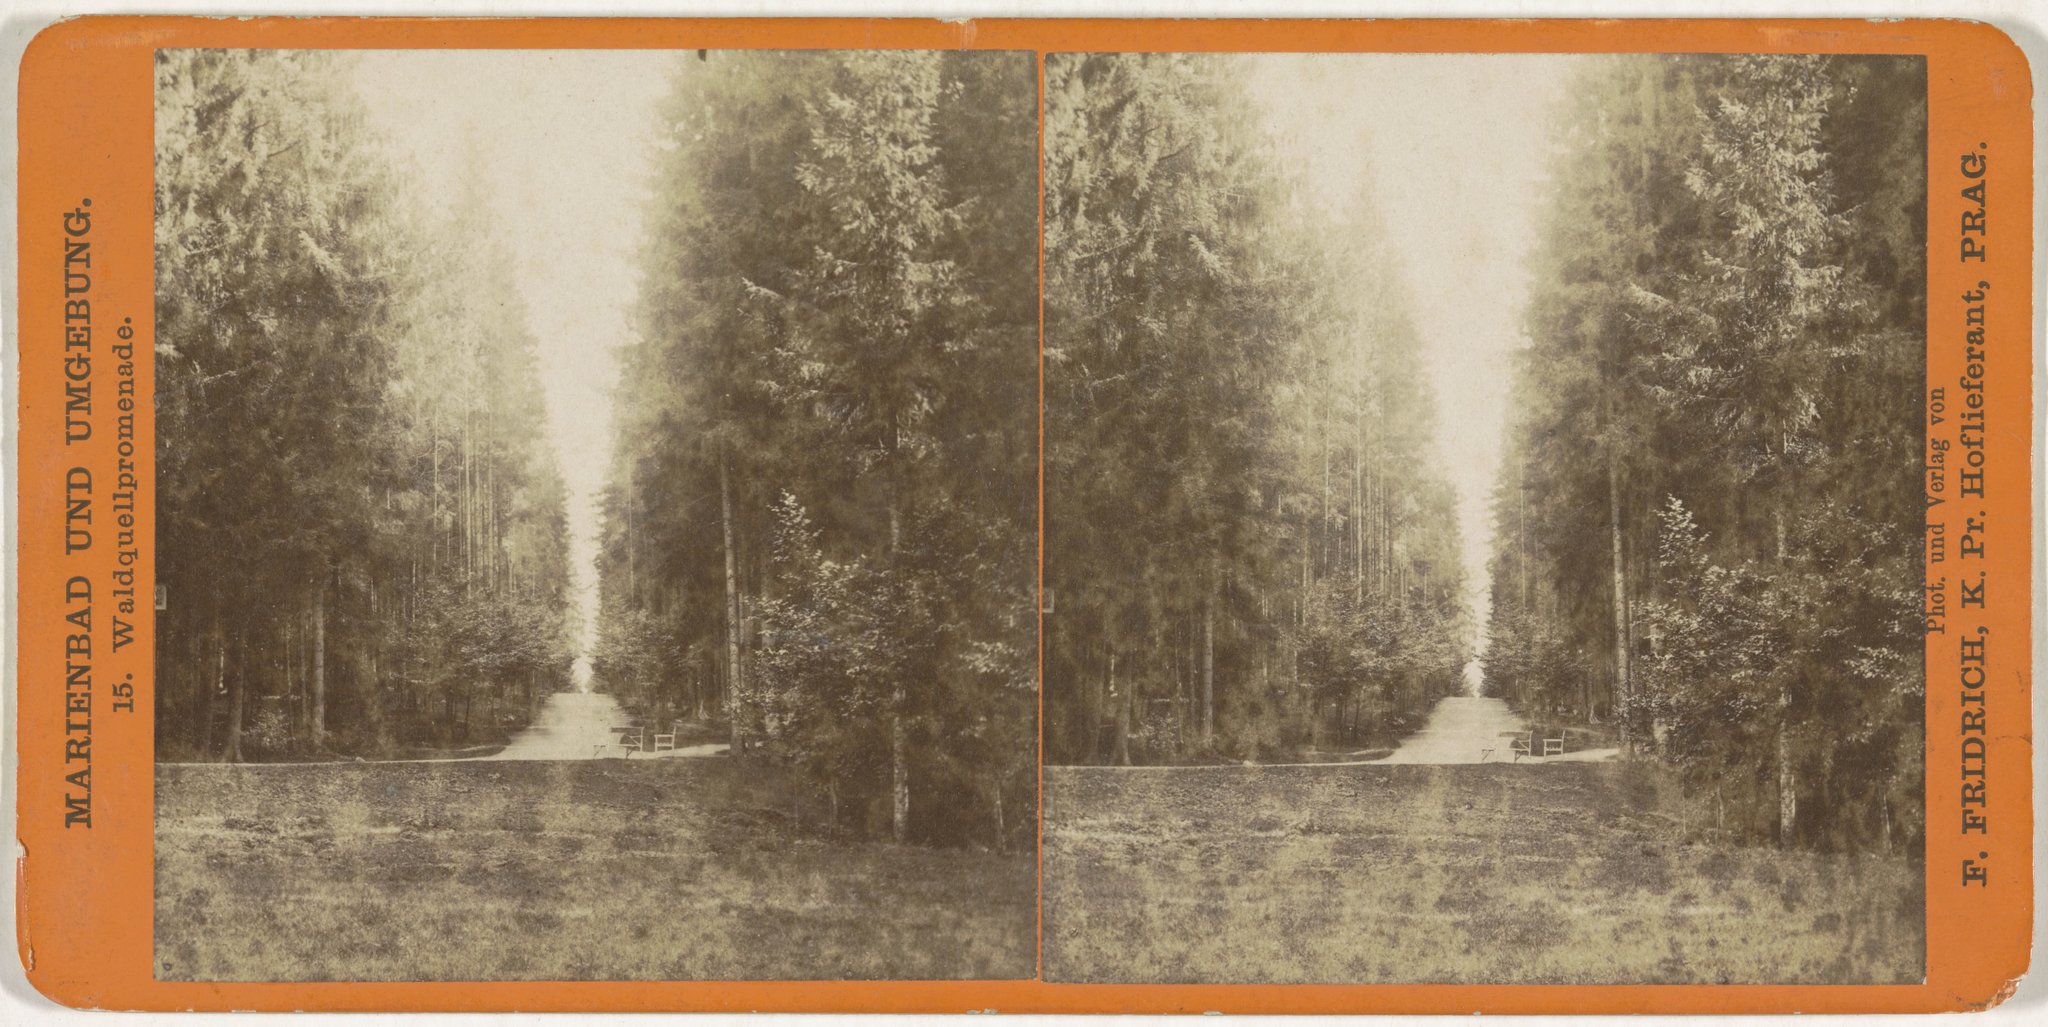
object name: stereograph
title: Marienbad und Umgebung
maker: františek fridrich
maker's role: publisher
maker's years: 1829-1892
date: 1855-1868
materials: cardboard, paper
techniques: albumen print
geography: prague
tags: forest path or lane, marienbad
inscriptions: inscription: ‘K. Pr. Hoflieferant’, number: ‘15’, number: ‘09’